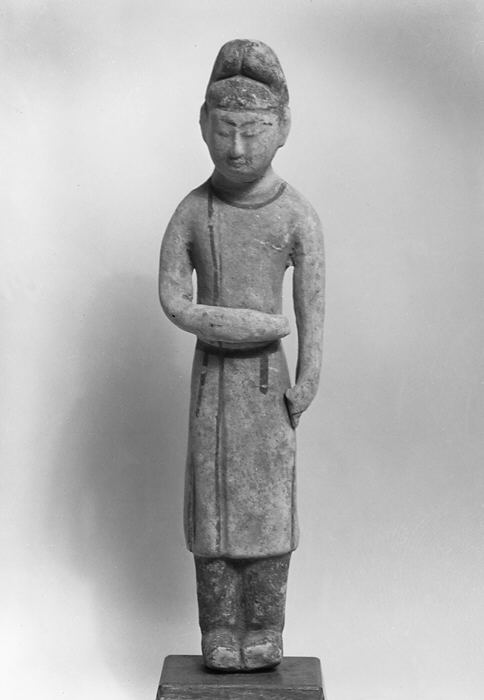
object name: figure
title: Male attendant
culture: chinese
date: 601-700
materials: clay, pigment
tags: men